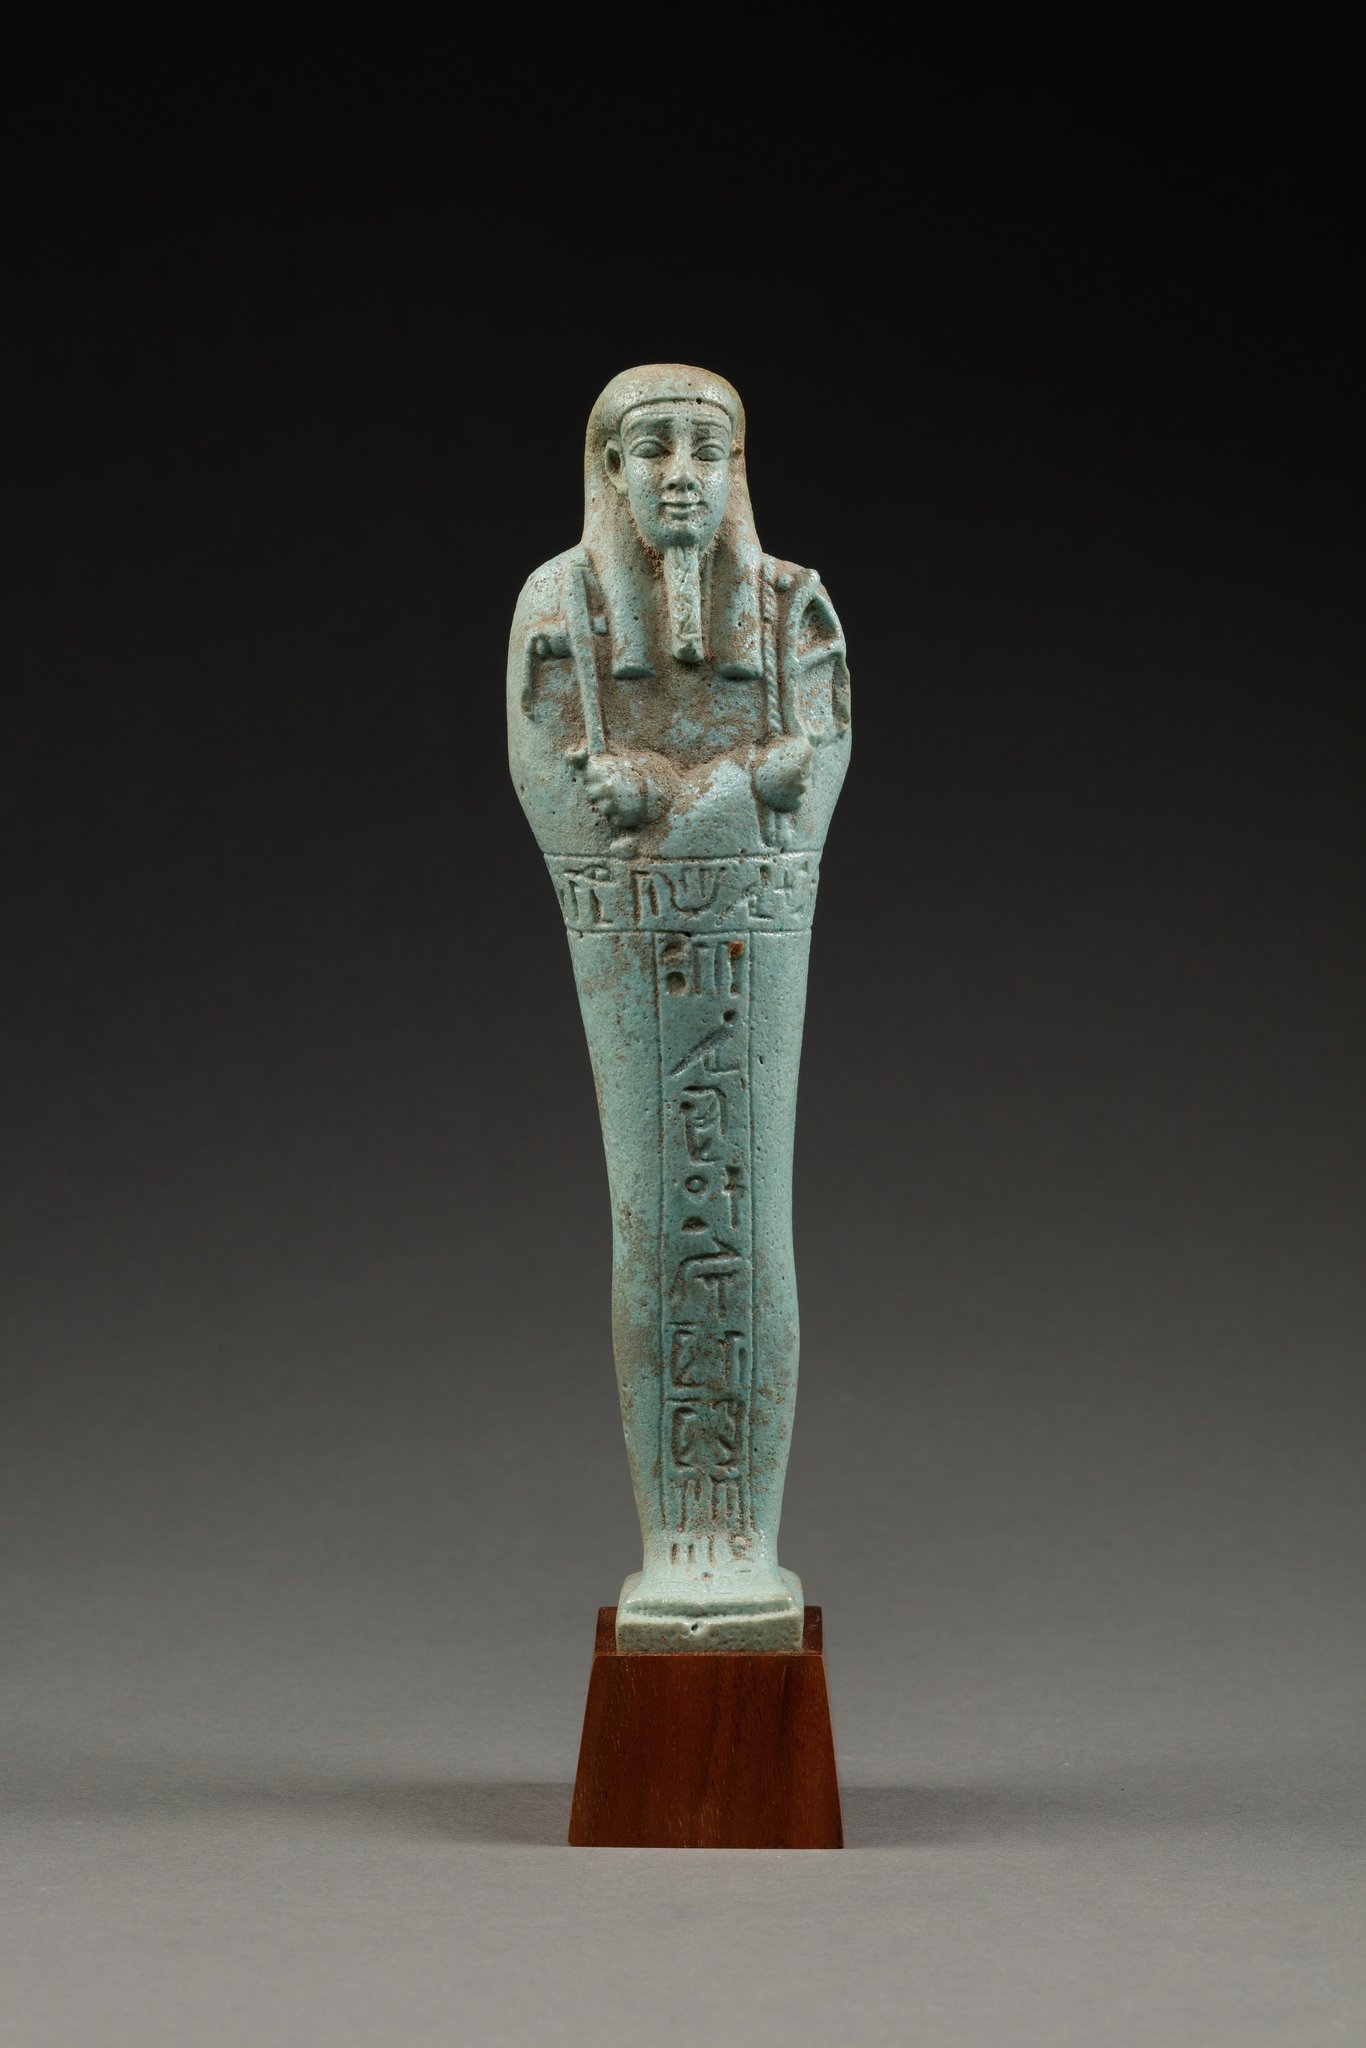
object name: shabti, nesbanebdjedet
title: Shabti inscribed for Nesbanebdjedet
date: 380-343 BCE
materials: faience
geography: eastern delta